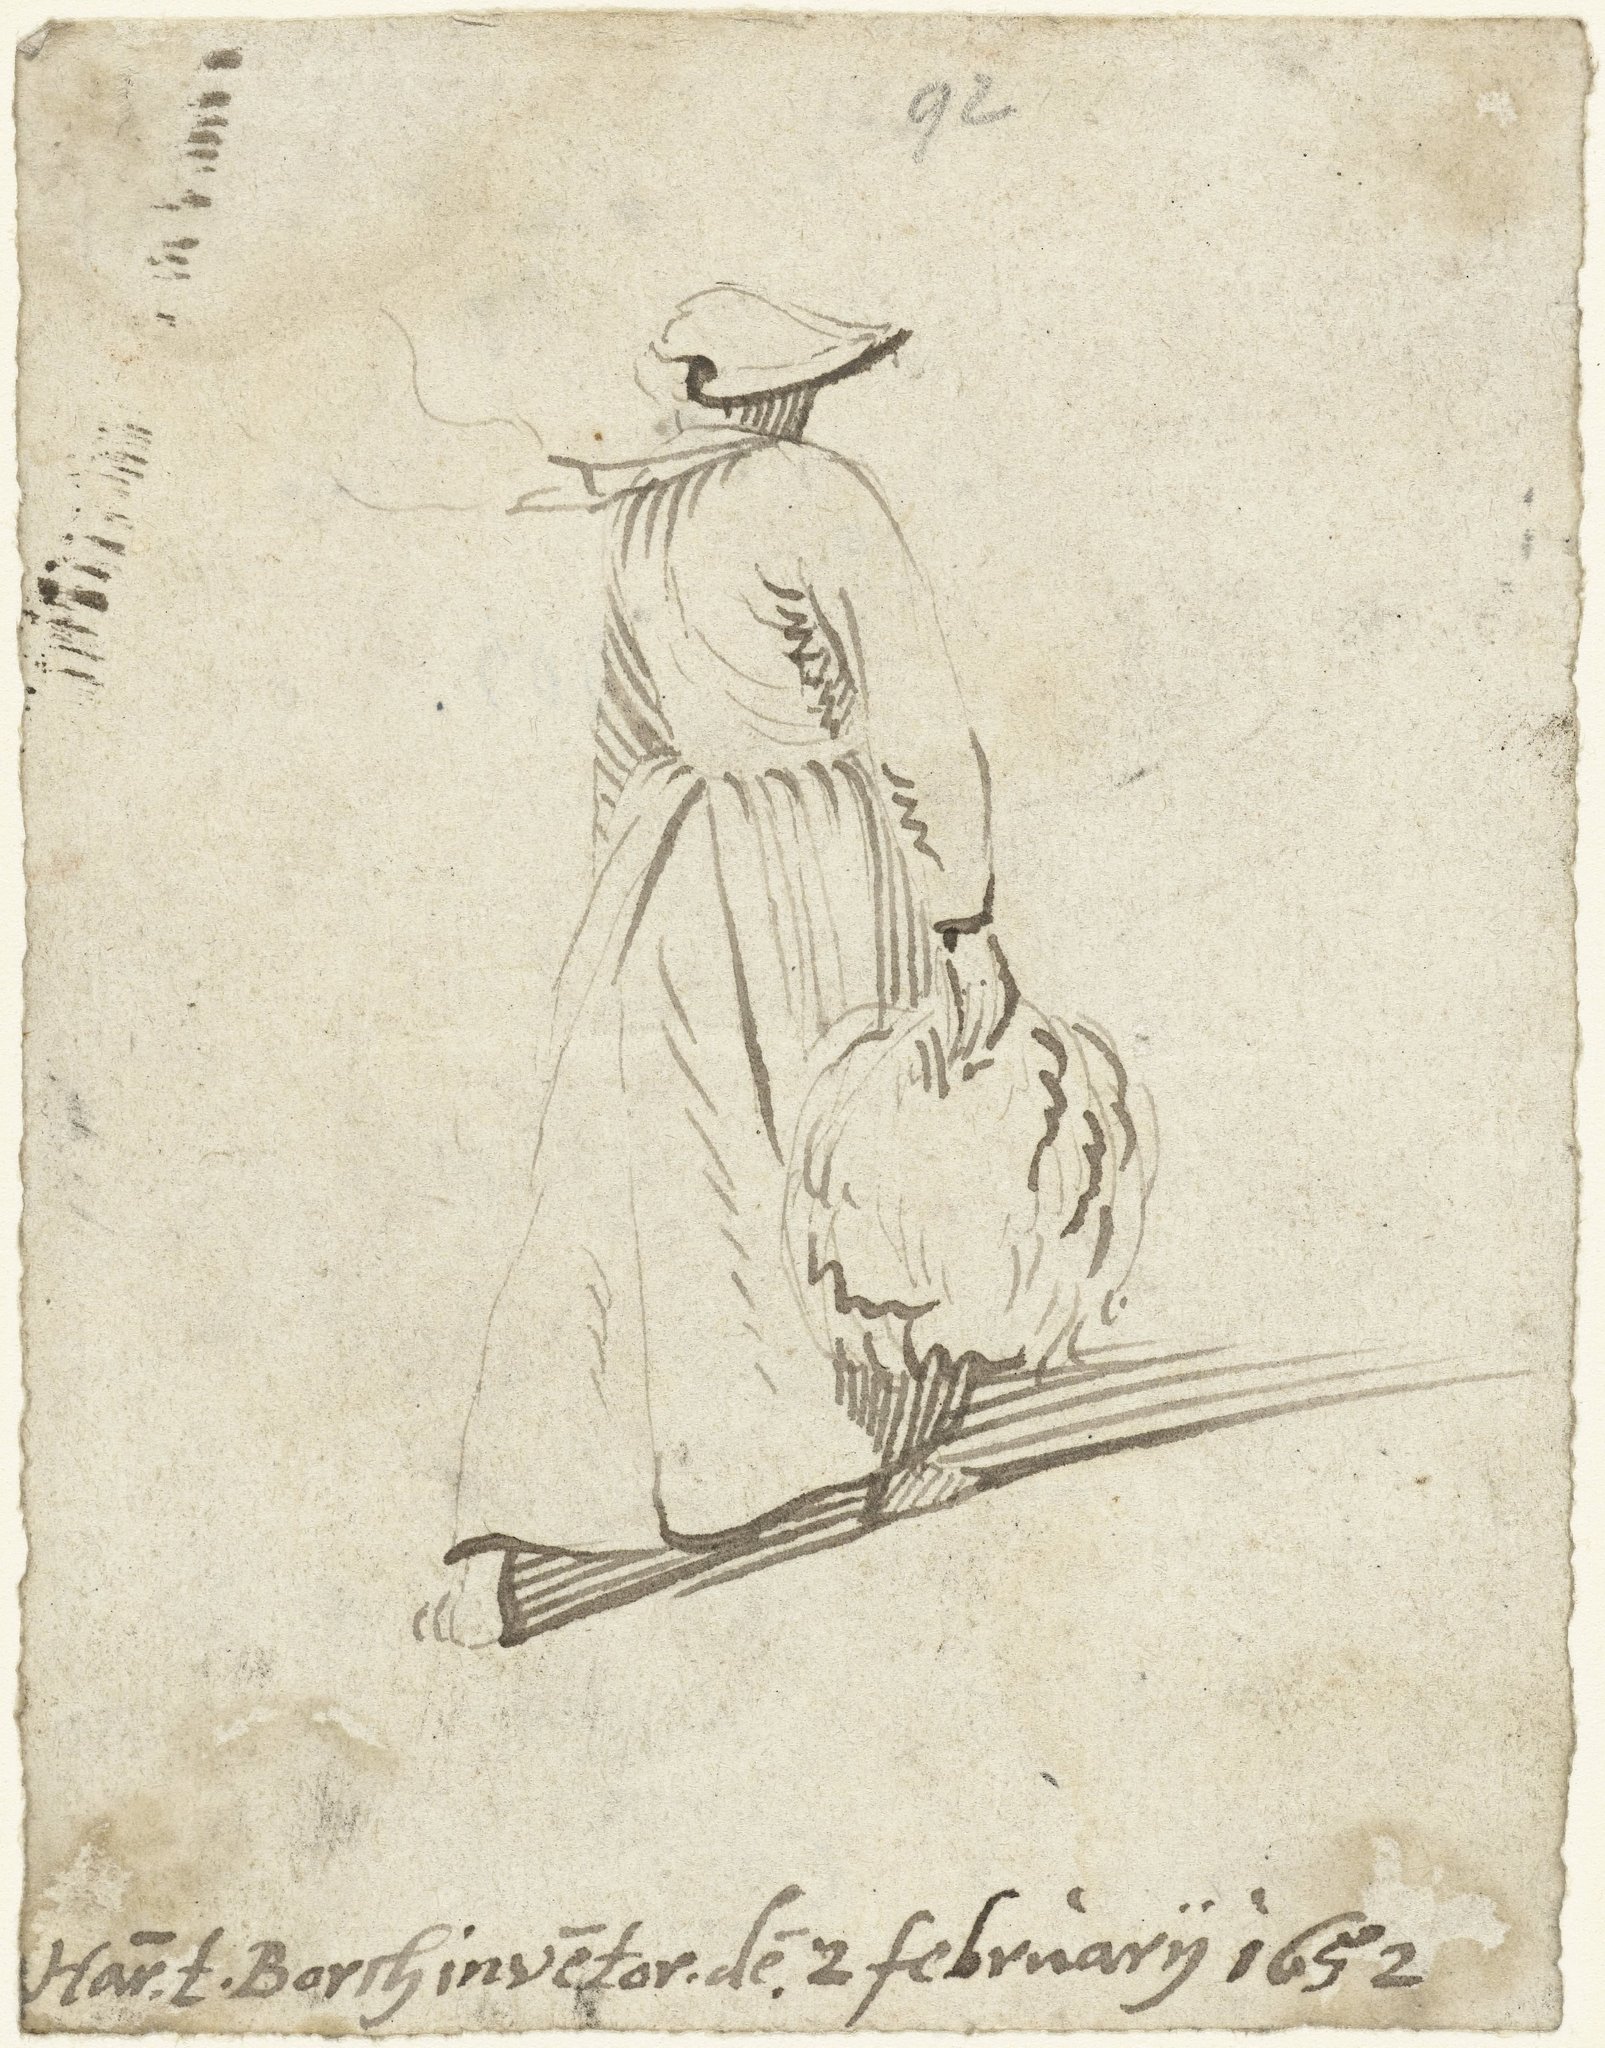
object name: drawing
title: Vrouw met wol in de hand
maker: harmen ter borch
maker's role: draughtsman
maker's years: 1638-1677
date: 1652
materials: ink, paper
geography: zwolle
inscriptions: annotation: ‘Har[man].t.Borch inve[n]tor. de[n].2 februarij 1652’